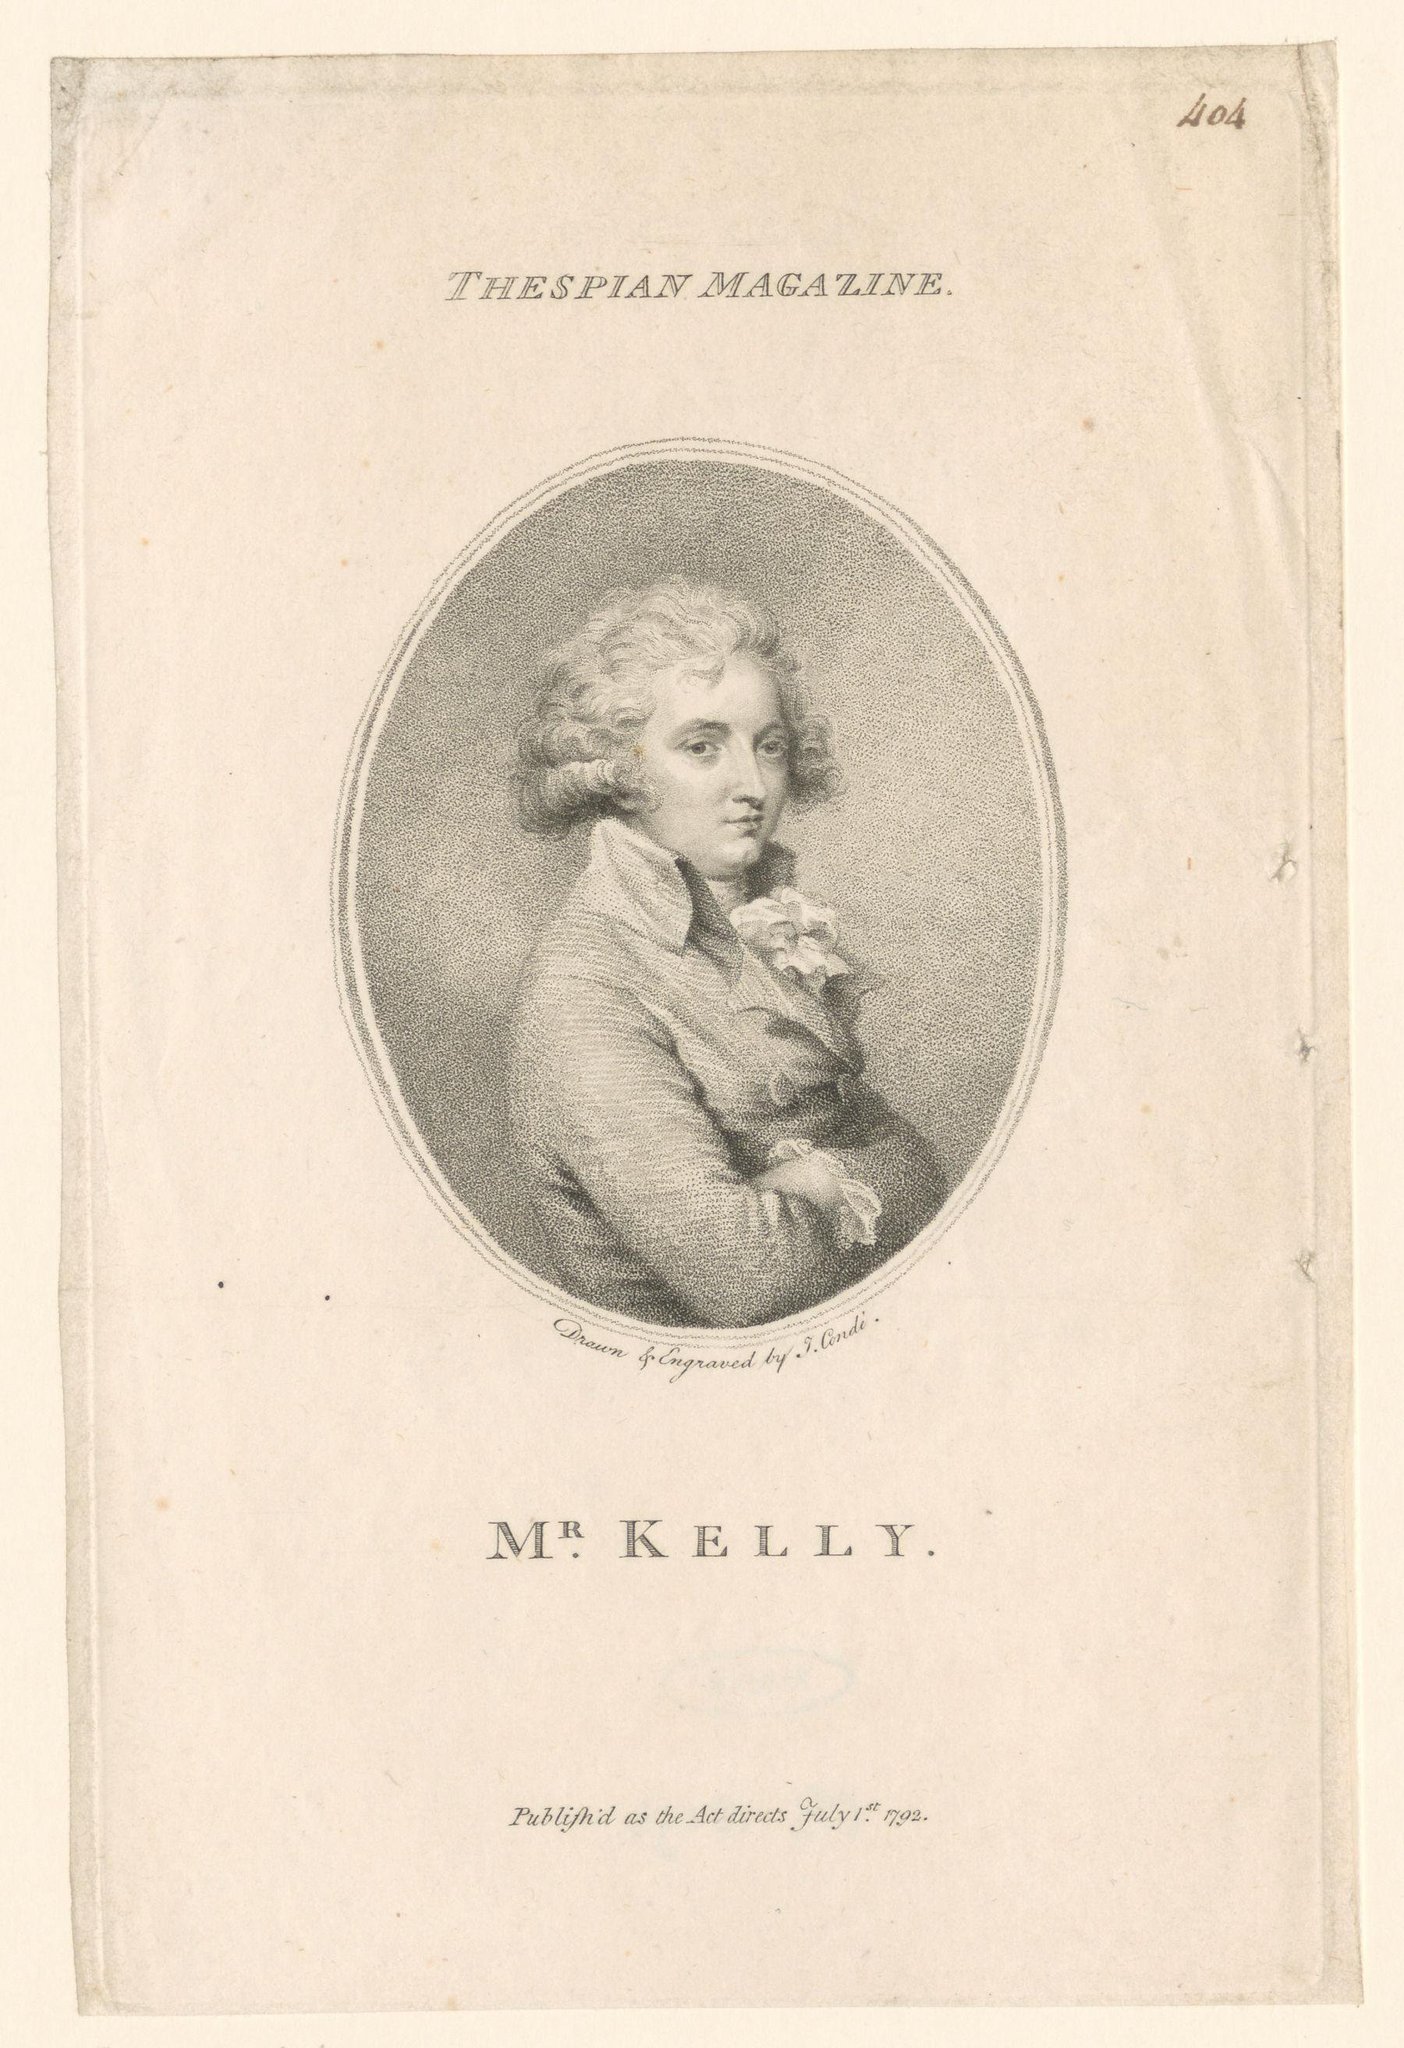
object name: print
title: Portret van Michael Kelly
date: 1792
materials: paper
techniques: stippling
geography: aldermanbury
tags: historical persons, portrait of composer, portrait of opera-singer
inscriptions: number: ‘404’, collector's mark: Lugt 2228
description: Prent gebruikt in: Thespian Magazine (1793).